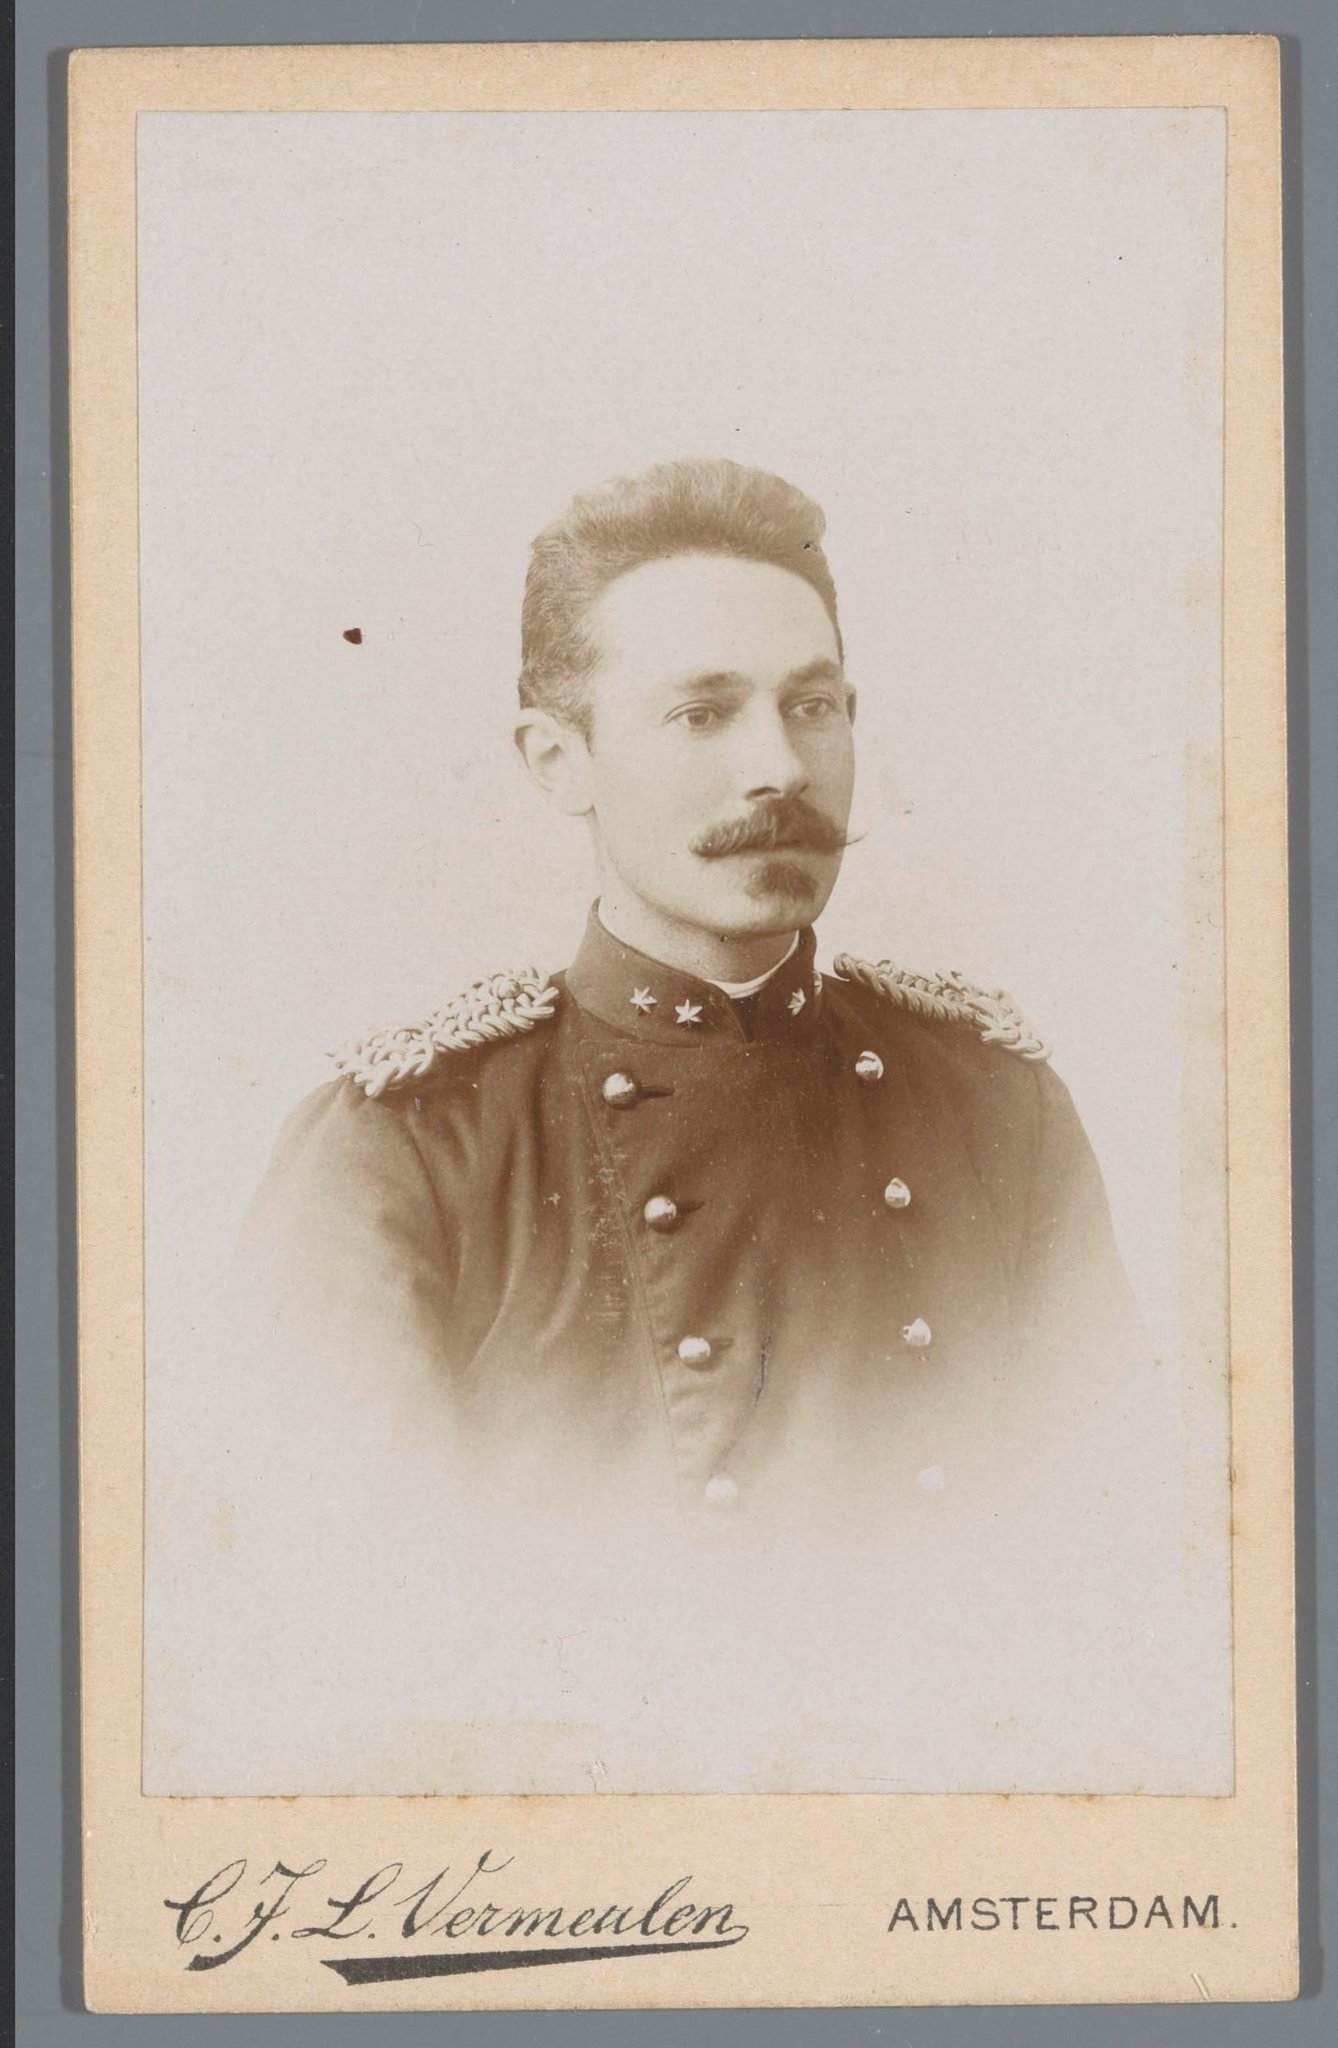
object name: photograph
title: Portret van een onbekende man met snor in uniform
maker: cornelis johannes lodewicus vermeulen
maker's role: fotograaf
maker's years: 1861-1936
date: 1888-1896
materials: paper, cardboard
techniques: collodion silver print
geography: amsterdam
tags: adult man, anonymous historical person portrayed, (military) uniforms, amsterdam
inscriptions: inscription: ‘C.J.L. Vermeulen Amsterdam.’, inscription: ‘C.J.L. Vermeulen/ Photographische Ateliers/ Amsterdam/ Heerenstraat 6 & Heiligenweg hoek Singel/ Specialiteit/ in Vergrootingen/ Telephoon/ 2339u40/ Block & Co, Berlin, S.W.’, monogram: ‘CV’